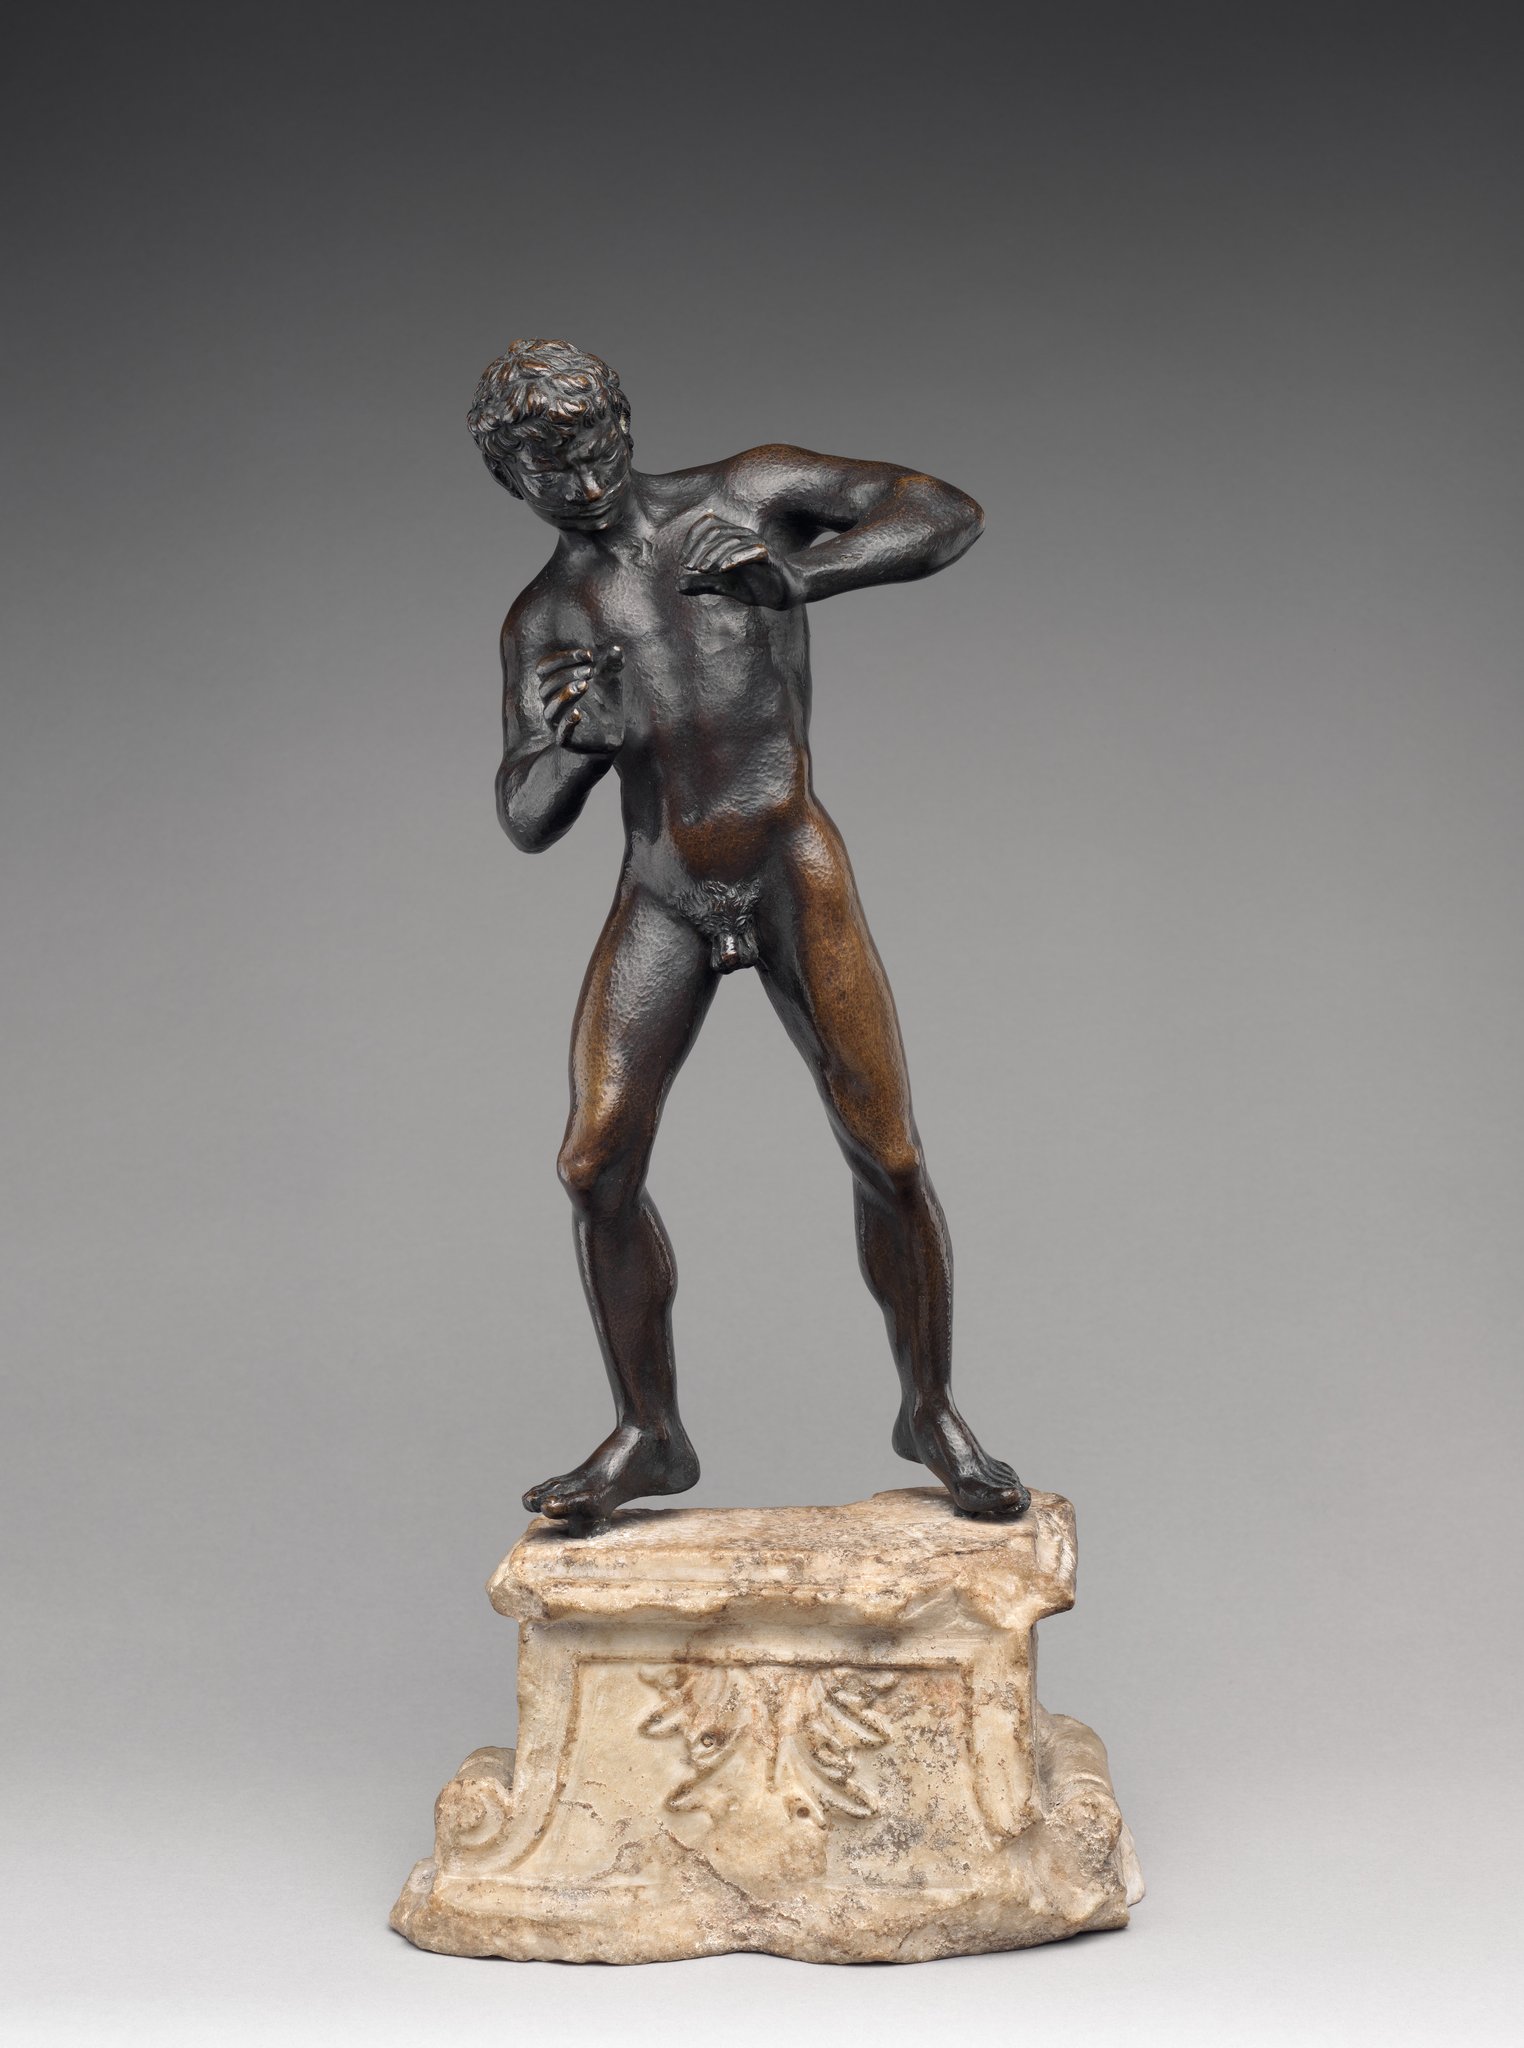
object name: statuette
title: Marsyas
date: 1801-1900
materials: bronze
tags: male nudes